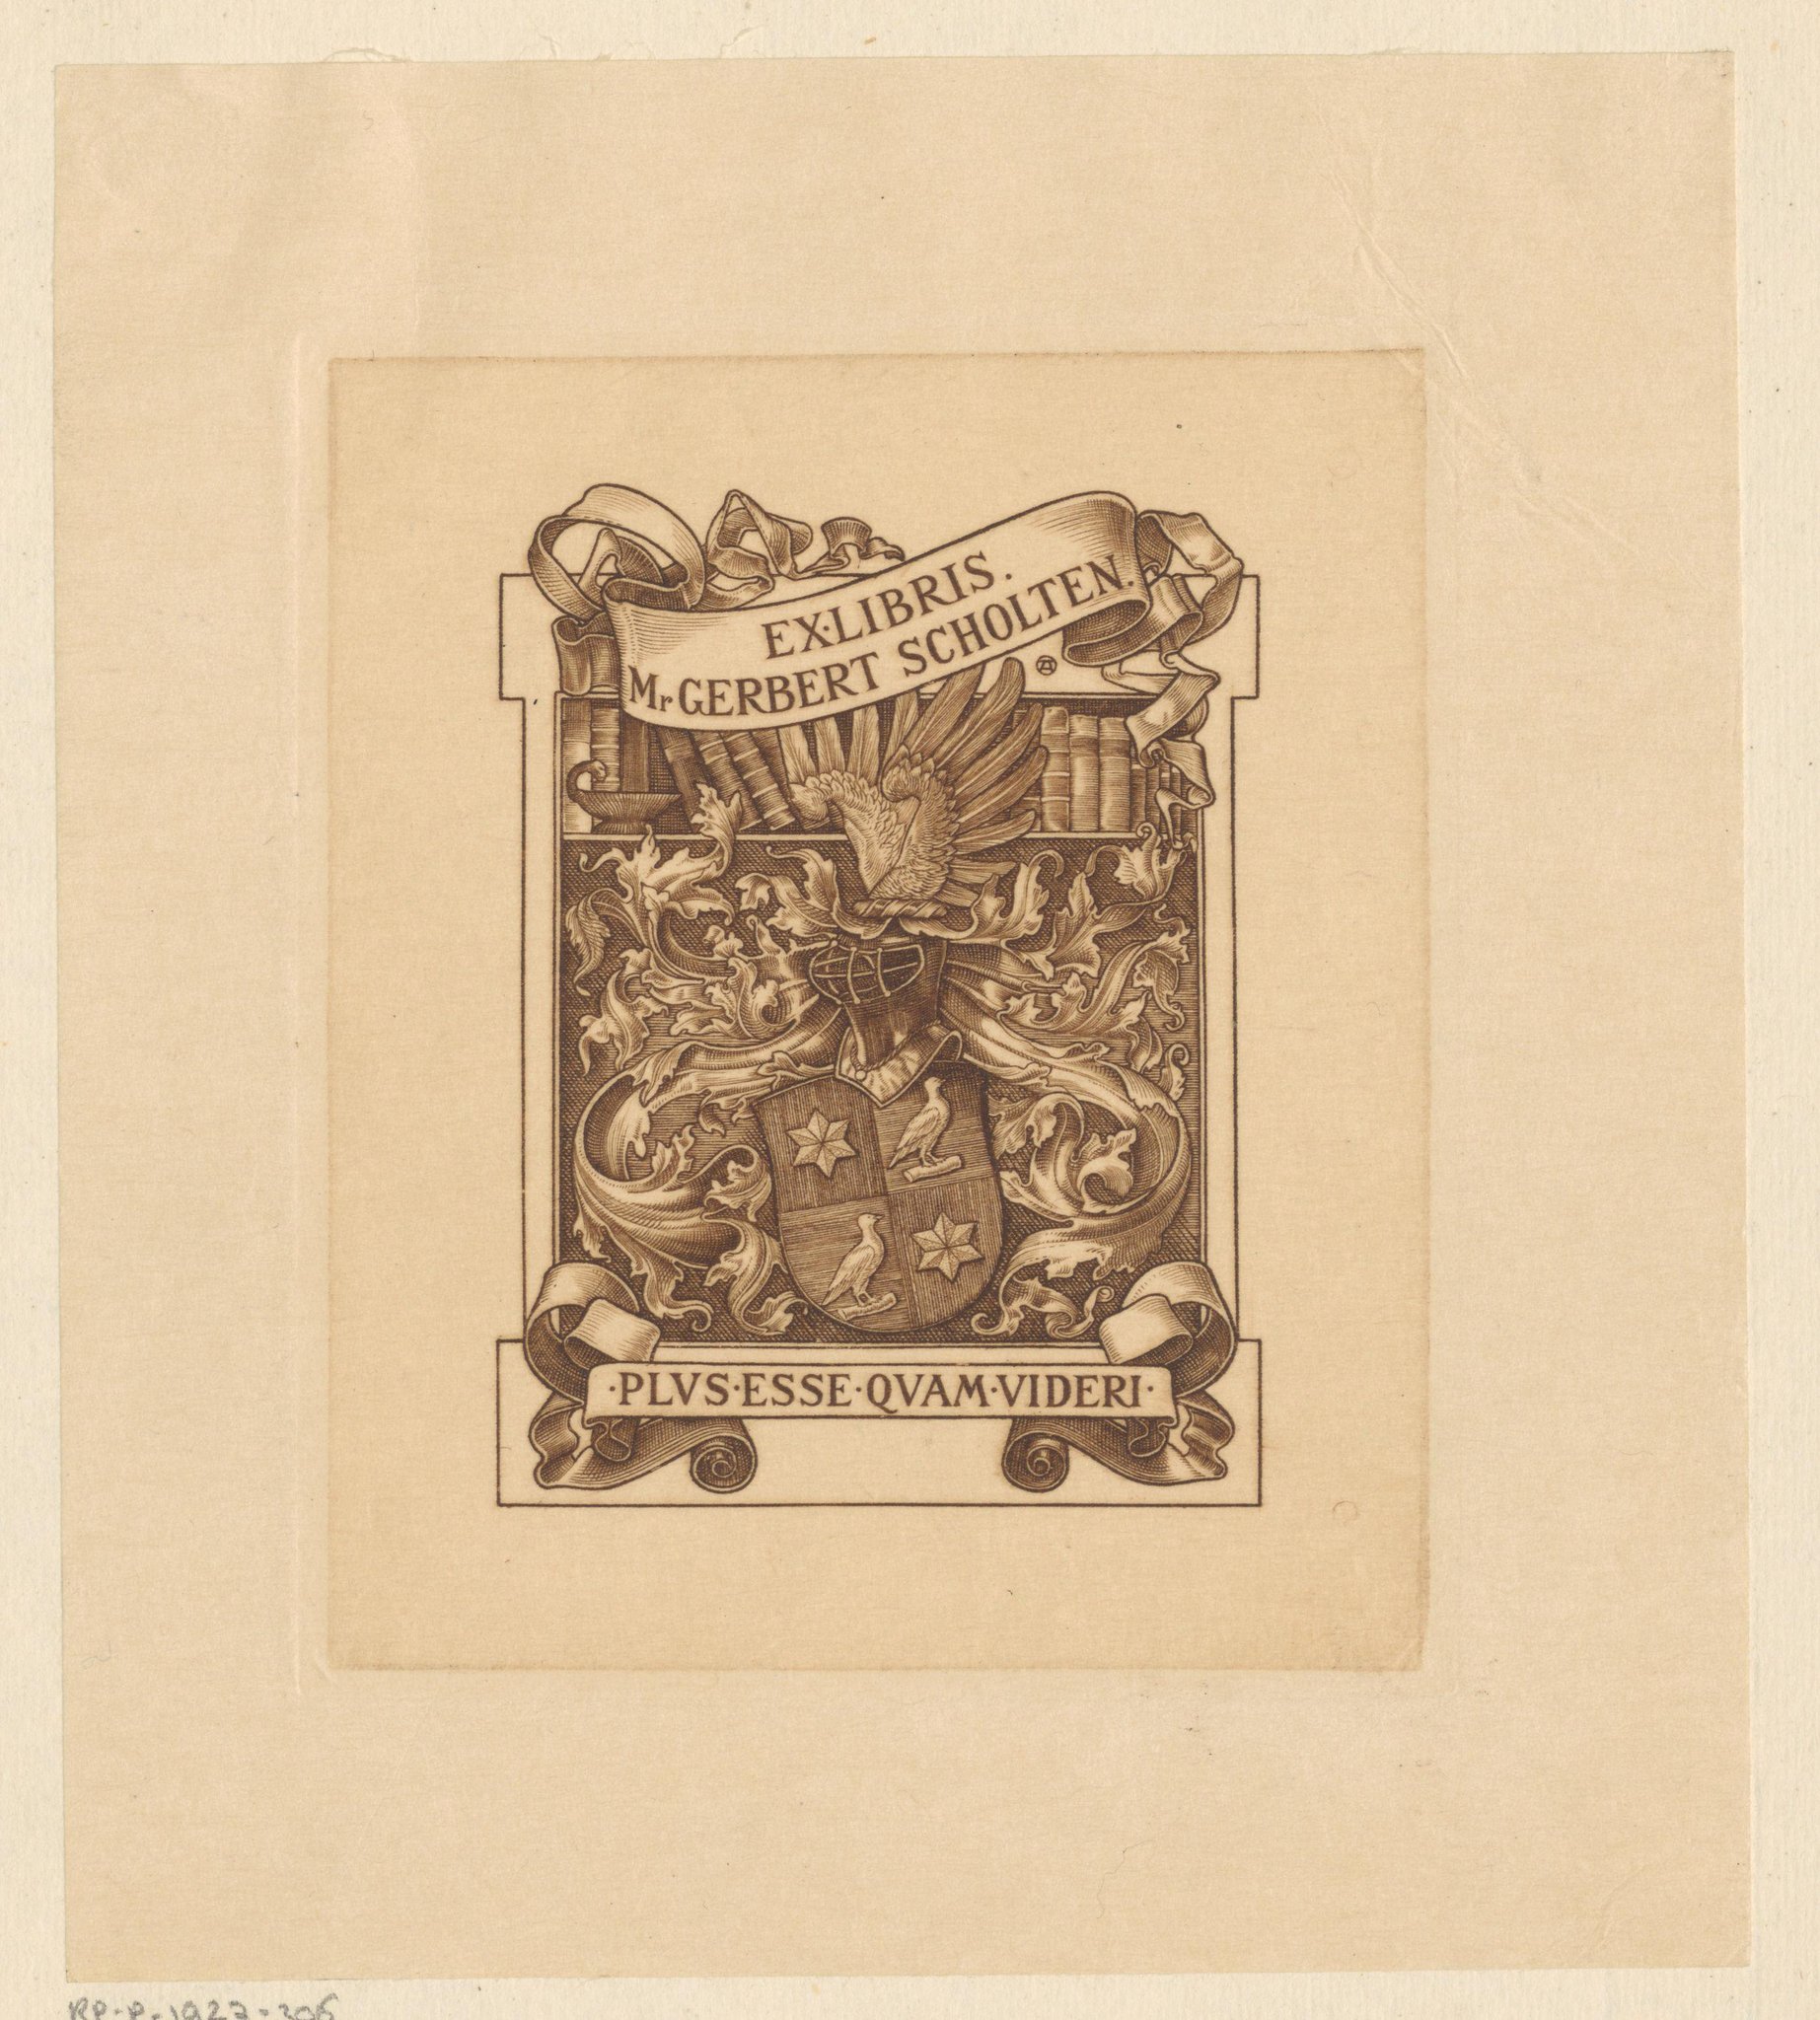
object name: bookplate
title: Ex libris van Gerbert Scholten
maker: johannes josephus aarts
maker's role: draughtsman, print maker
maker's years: 1871-1934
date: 1914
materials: paper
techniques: engraving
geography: netherlands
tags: book, armorial bearing, heraldry